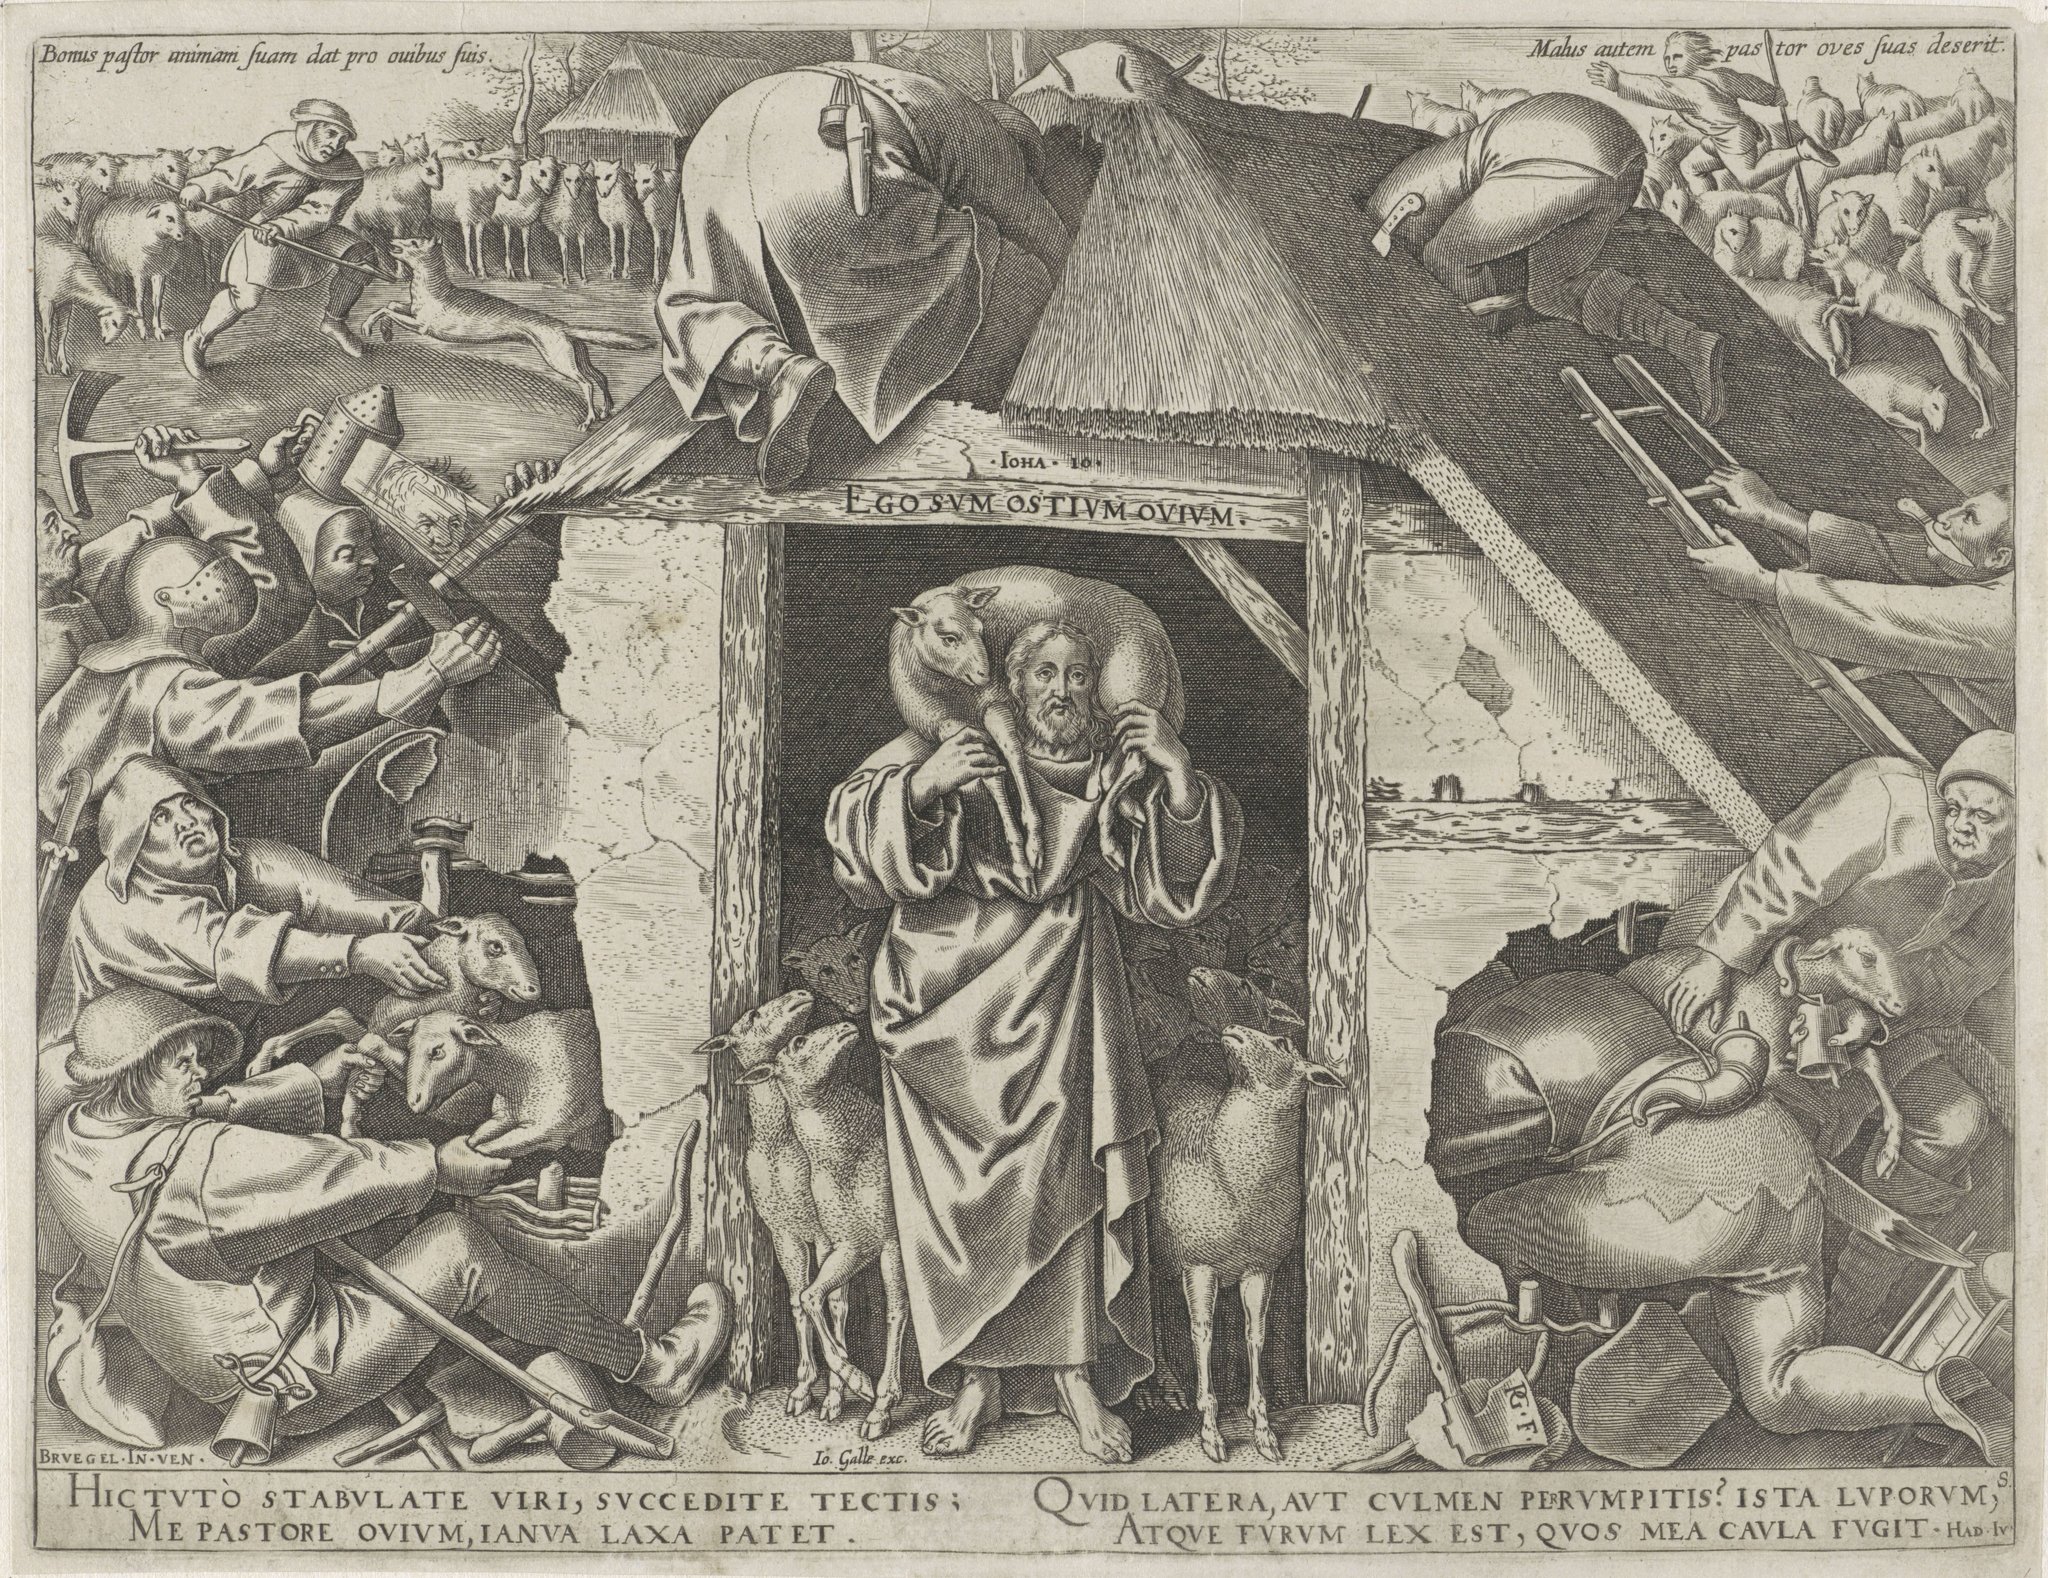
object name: print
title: Gelijkenis van Christus als de goede herder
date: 1571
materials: paper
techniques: engraving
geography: antwerp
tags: 'i am the door of the sheep' ~ parable of the good shepherd, christ as good shepherd, 'thieves and robbers' climb on the roof of the sheepfold ~ parable of the good shepherd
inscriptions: collector's mark: Lugt 2228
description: Christus staande in de deur naar de schaapskooi met een lam op de schouders. Via de zijmuren en het dak proberen dieven binnen te dringen en schapen uit de stal te stelen. Op de achtergrond links verjaagt een goede herder een wolf van de kudde. Op de achtergrond rechts rent een gehuurde herder weg als er een wolf komt. Met een onderschrift van twee keer twee regels in het Latijn, boven de deur van de schuur een verwijzing naar Joh. 10. Spotprent op de Roomse Kerk.